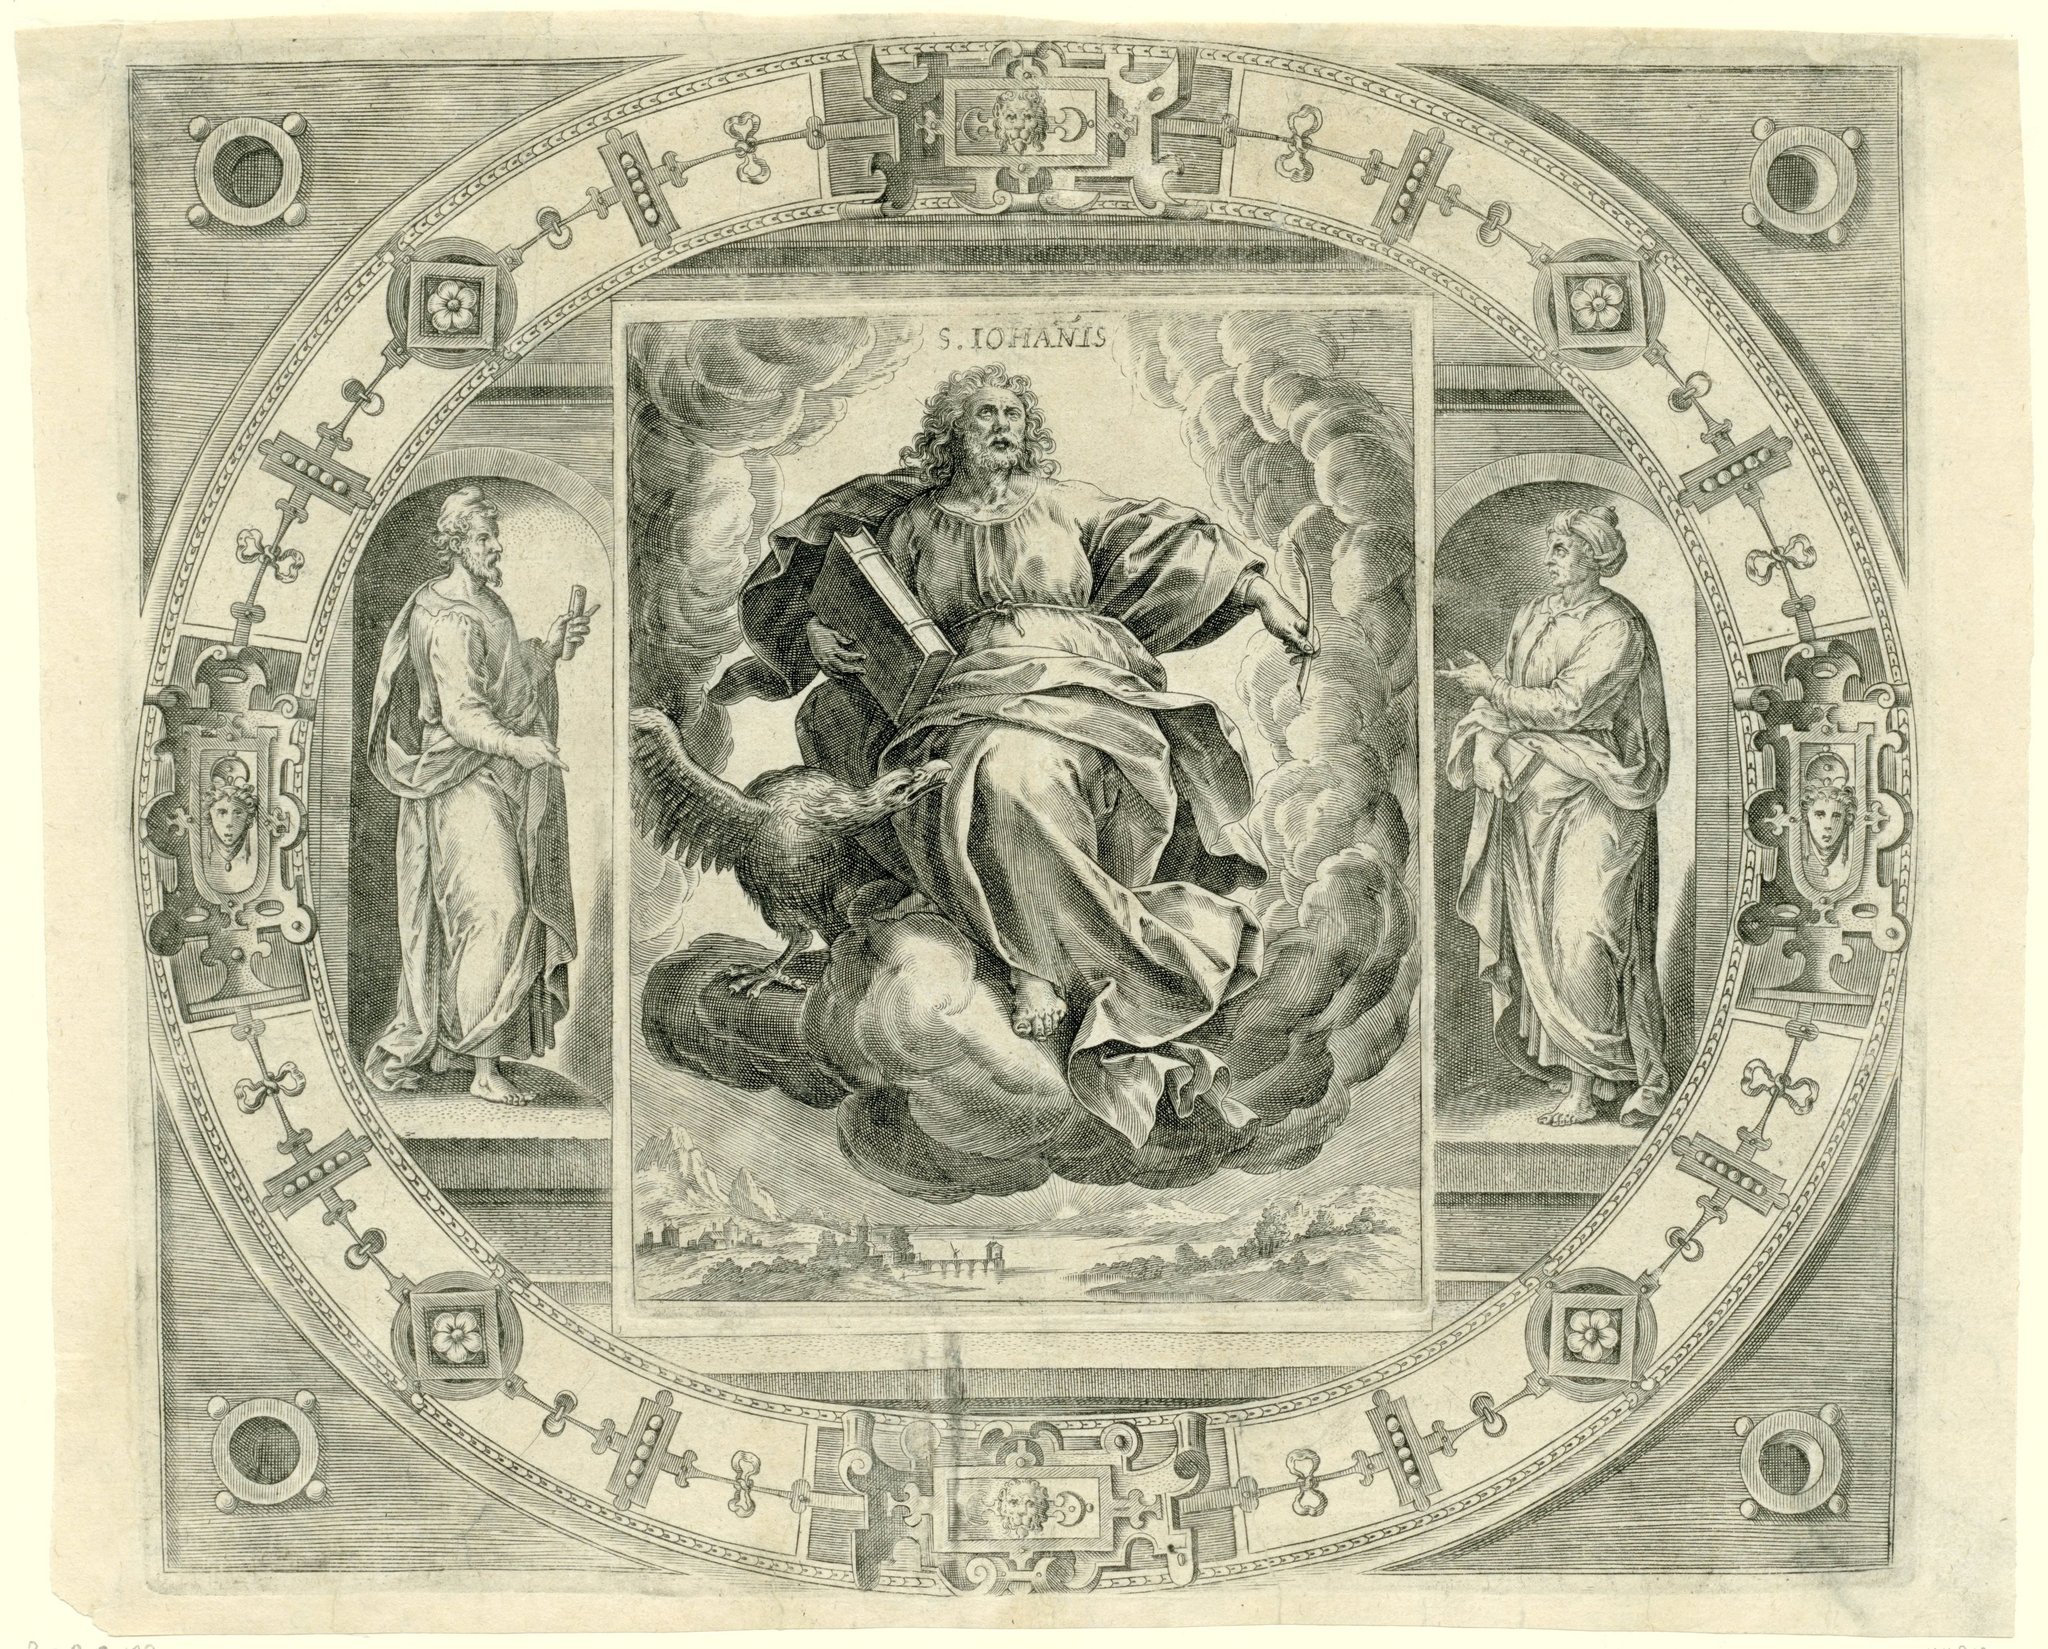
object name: print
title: De vier evangelisten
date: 1585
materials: paper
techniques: engraving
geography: antwerp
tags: ornaments ~ art, st. john the evangelist writing the gospel, usually the eagle present, male persons from the old testament (not in biblical context)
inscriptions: collector's mark: Lugt 2228, title: ‘S. IOHANIS’, collector's mark: Lugt 2760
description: De evangelist Johannes, op een wolk, met zijn attribuut de adelaar naast zich. In zijn ene hand het evangelieboek, in zijn andere een schrijfveer. De voorstelling is gevat in een ornamentale omlijsting met aan weerszijden een profeet in een nis.